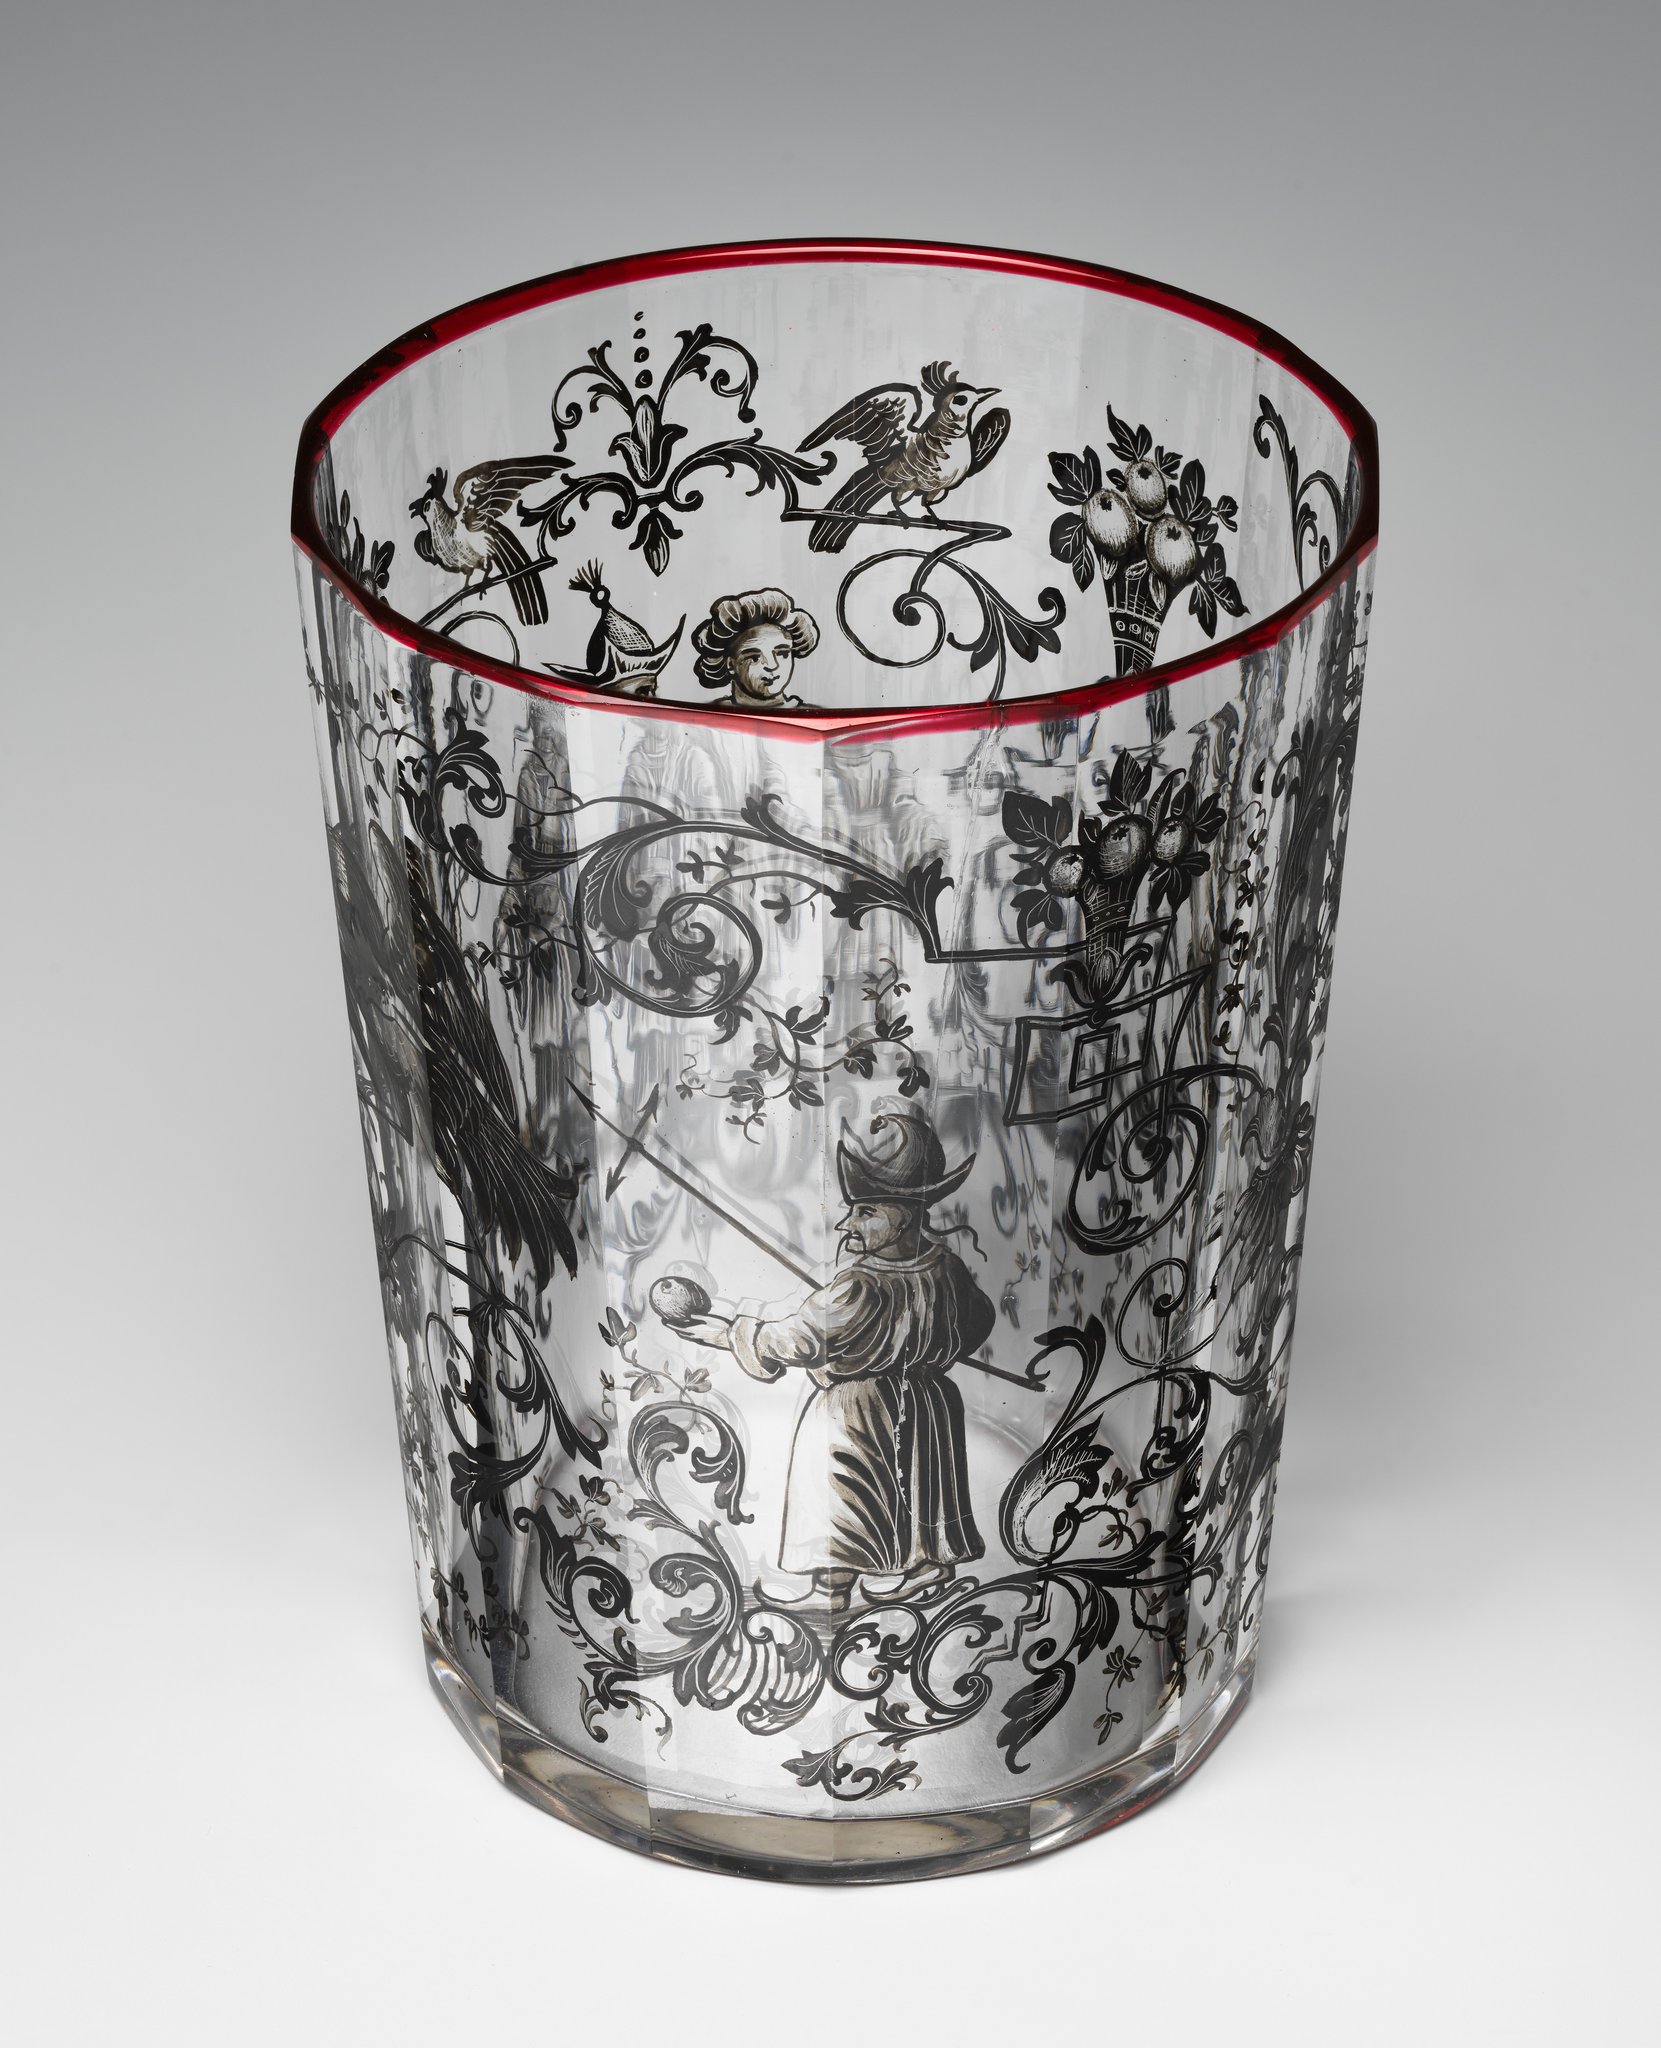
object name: tumbler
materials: glass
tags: birds